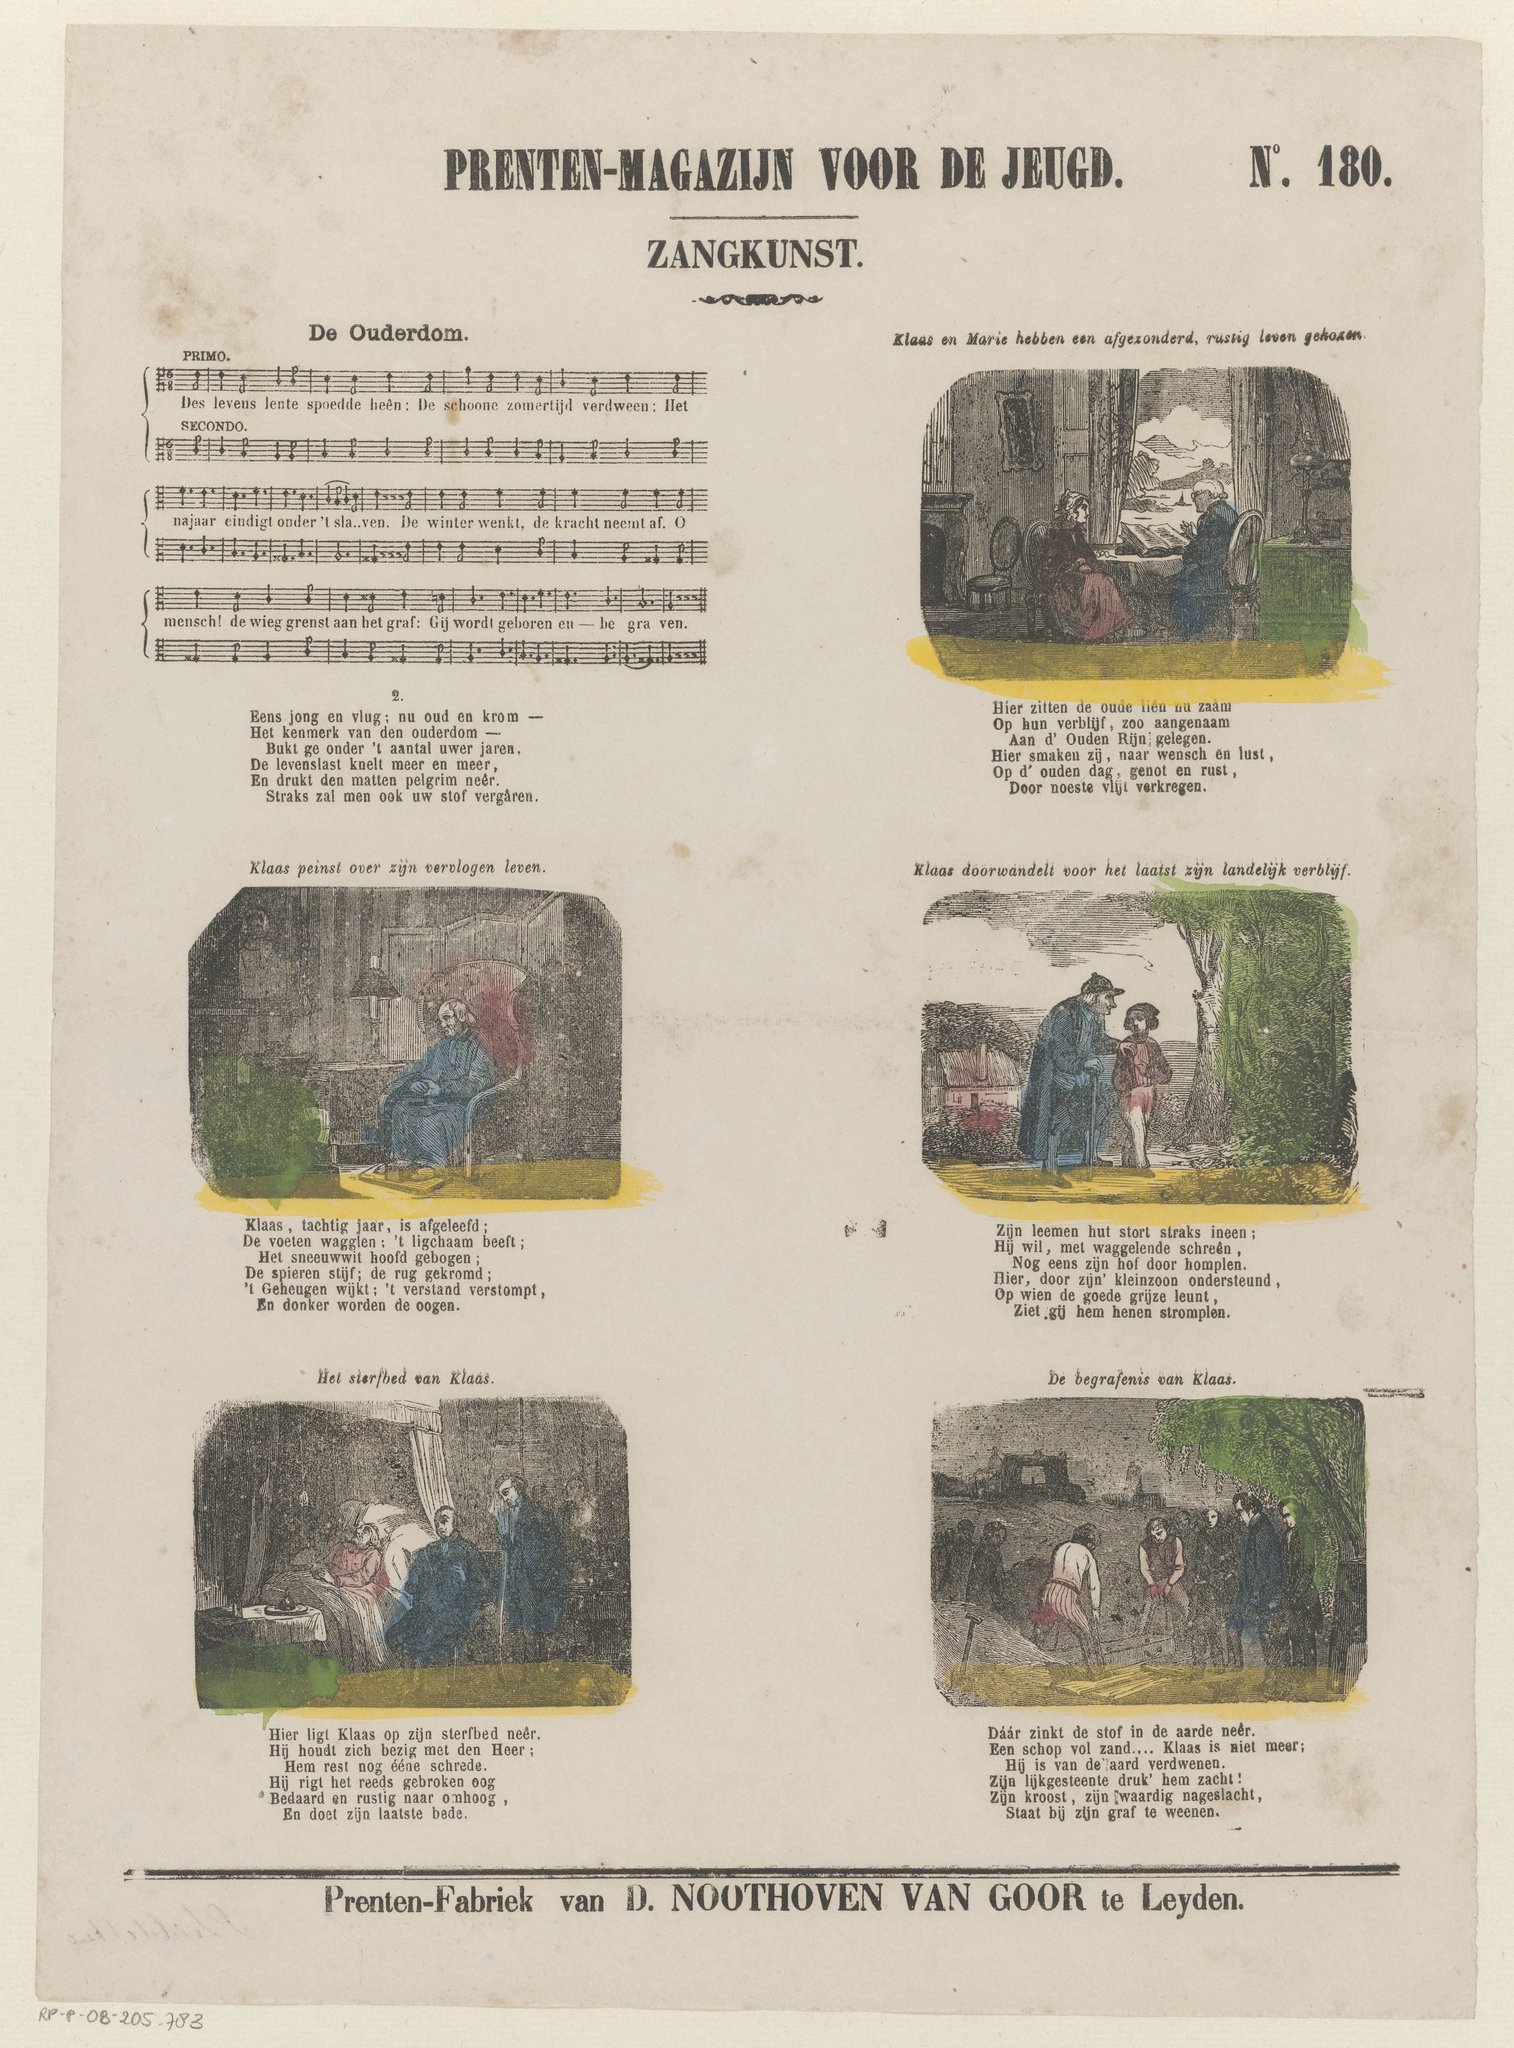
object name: popular print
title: Prenten-magazijn voor de jeugd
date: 1850-1881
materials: paper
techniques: colour, letterpress printing, engraving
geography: netherlands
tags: burial, old man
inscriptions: collector's mark: Lugt 2760, inscription: ‘P. Leidekker’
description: Blad met 5 voorstellingen en een stuk bladmuziek met een lied over het leven van een oude man genaamd Klaas. Boven elke voorstelling een titel en onder elke voorstelling coupletten van het lied. Genummerd rechtsboven: No. 180.